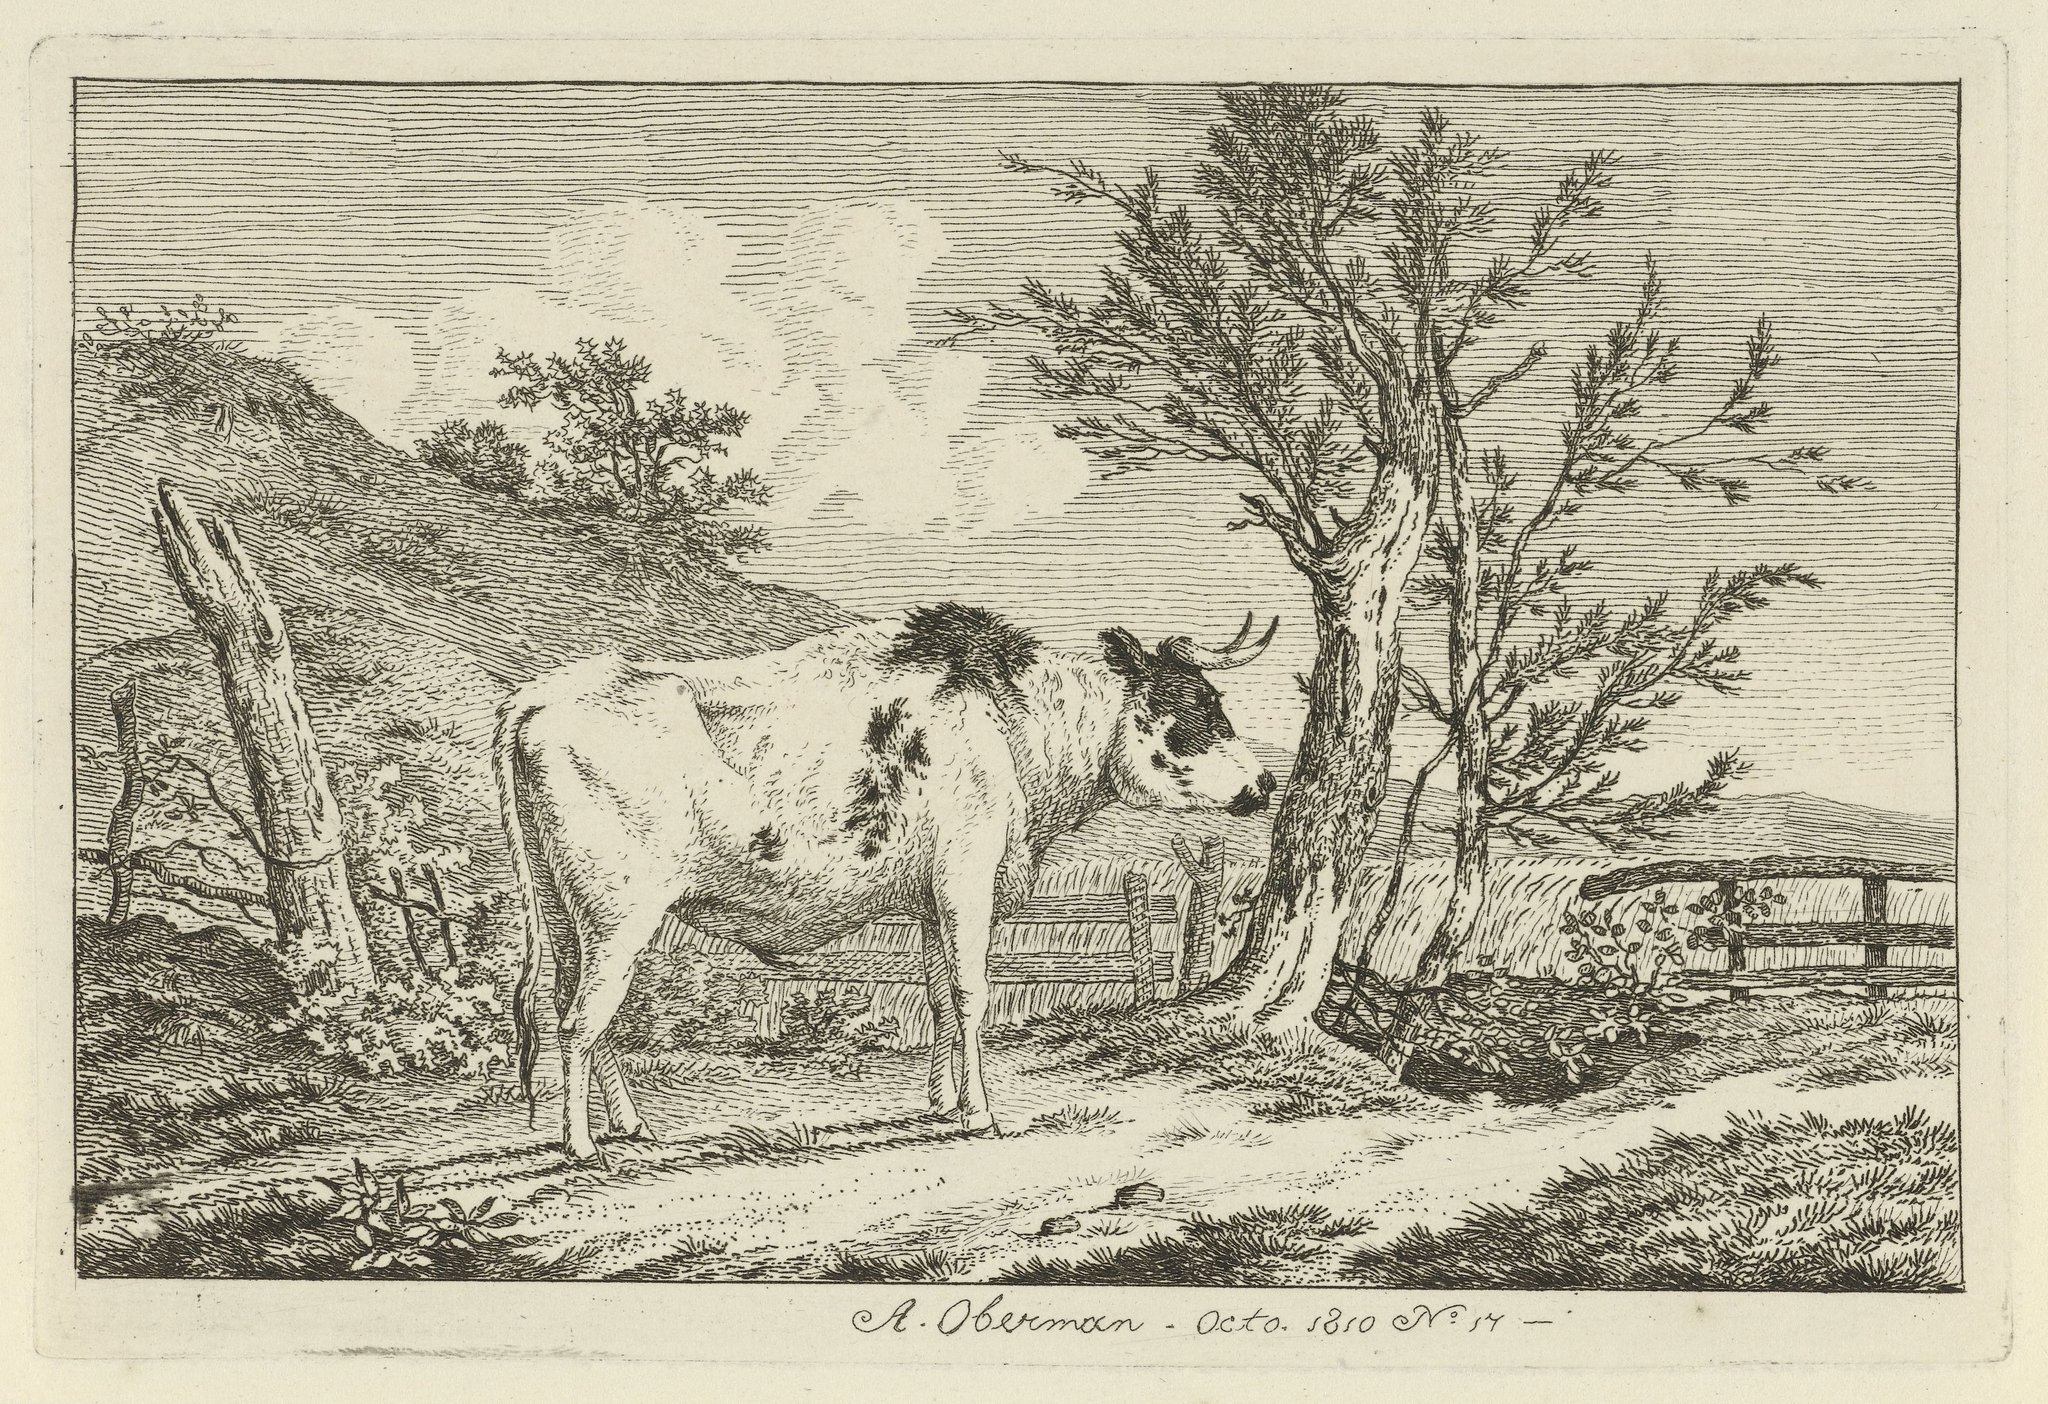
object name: print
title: Studies van koeien, schapen en geiten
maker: anthony oberman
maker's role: draughtsman, painter, print maker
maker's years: 1781-1845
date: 1810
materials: paper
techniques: etching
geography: amsterdam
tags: bull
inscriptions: collector's mark: Lugt 2228